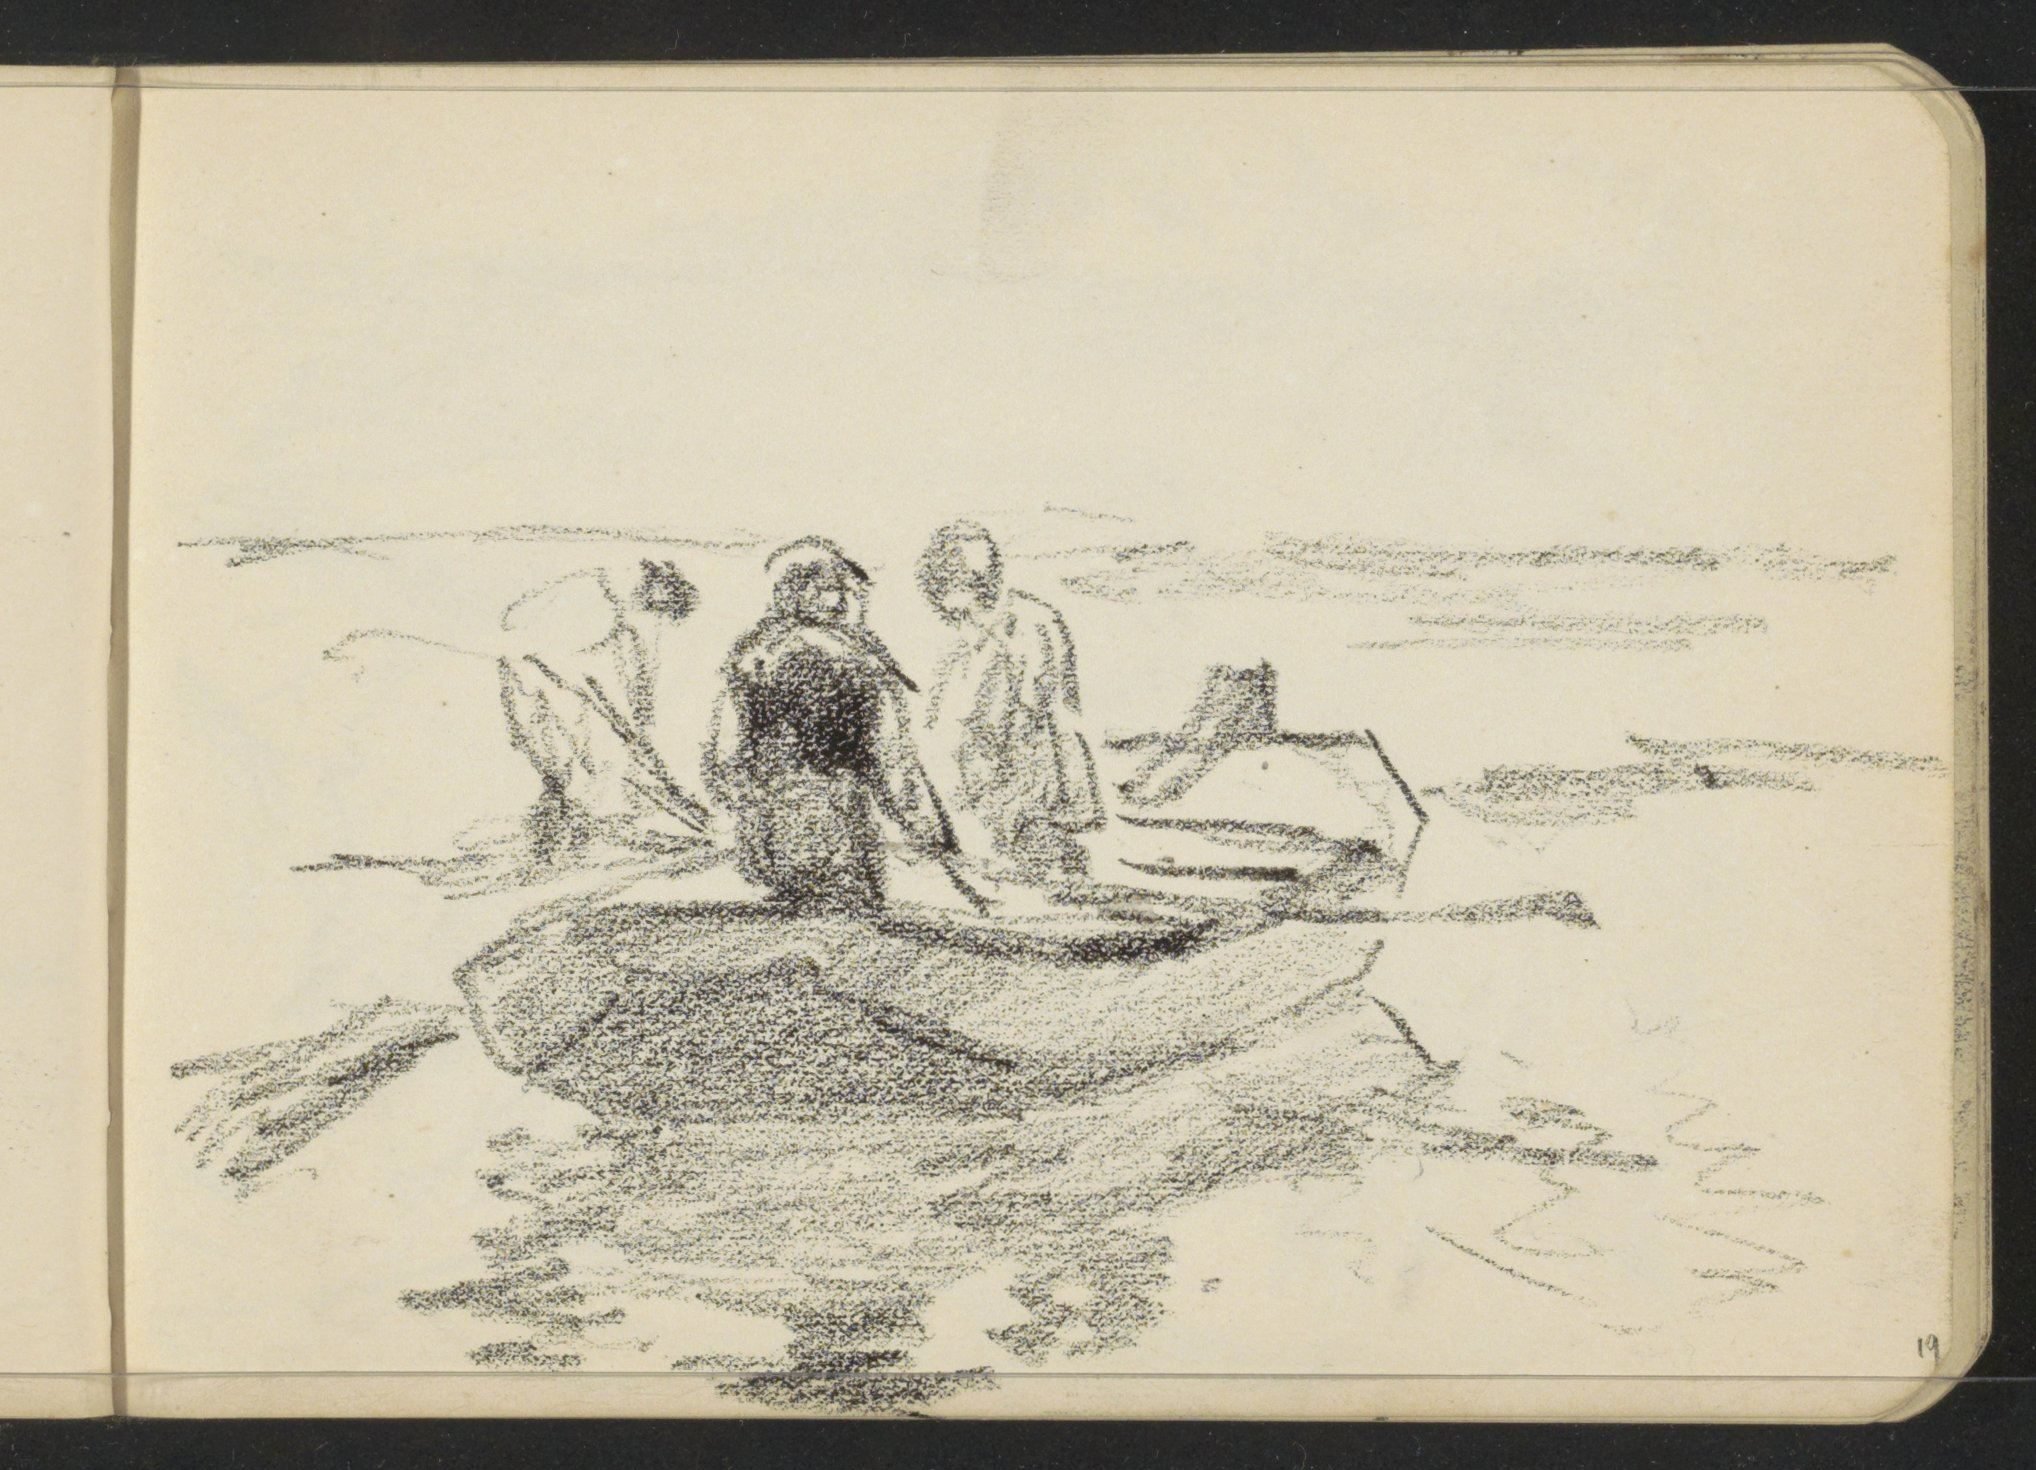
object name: sketchbook leaf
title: Twee mannen in een roeiboot naast een schelpenvisser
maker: willem cornelis rip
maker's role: draughtsman, painter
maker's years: 1856-1922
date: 1914-1916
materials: chalk, paper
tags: rowing-boat, canoe, etc., fisherman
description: Blad 19 recto uit een schetsboek met 41 bladen.